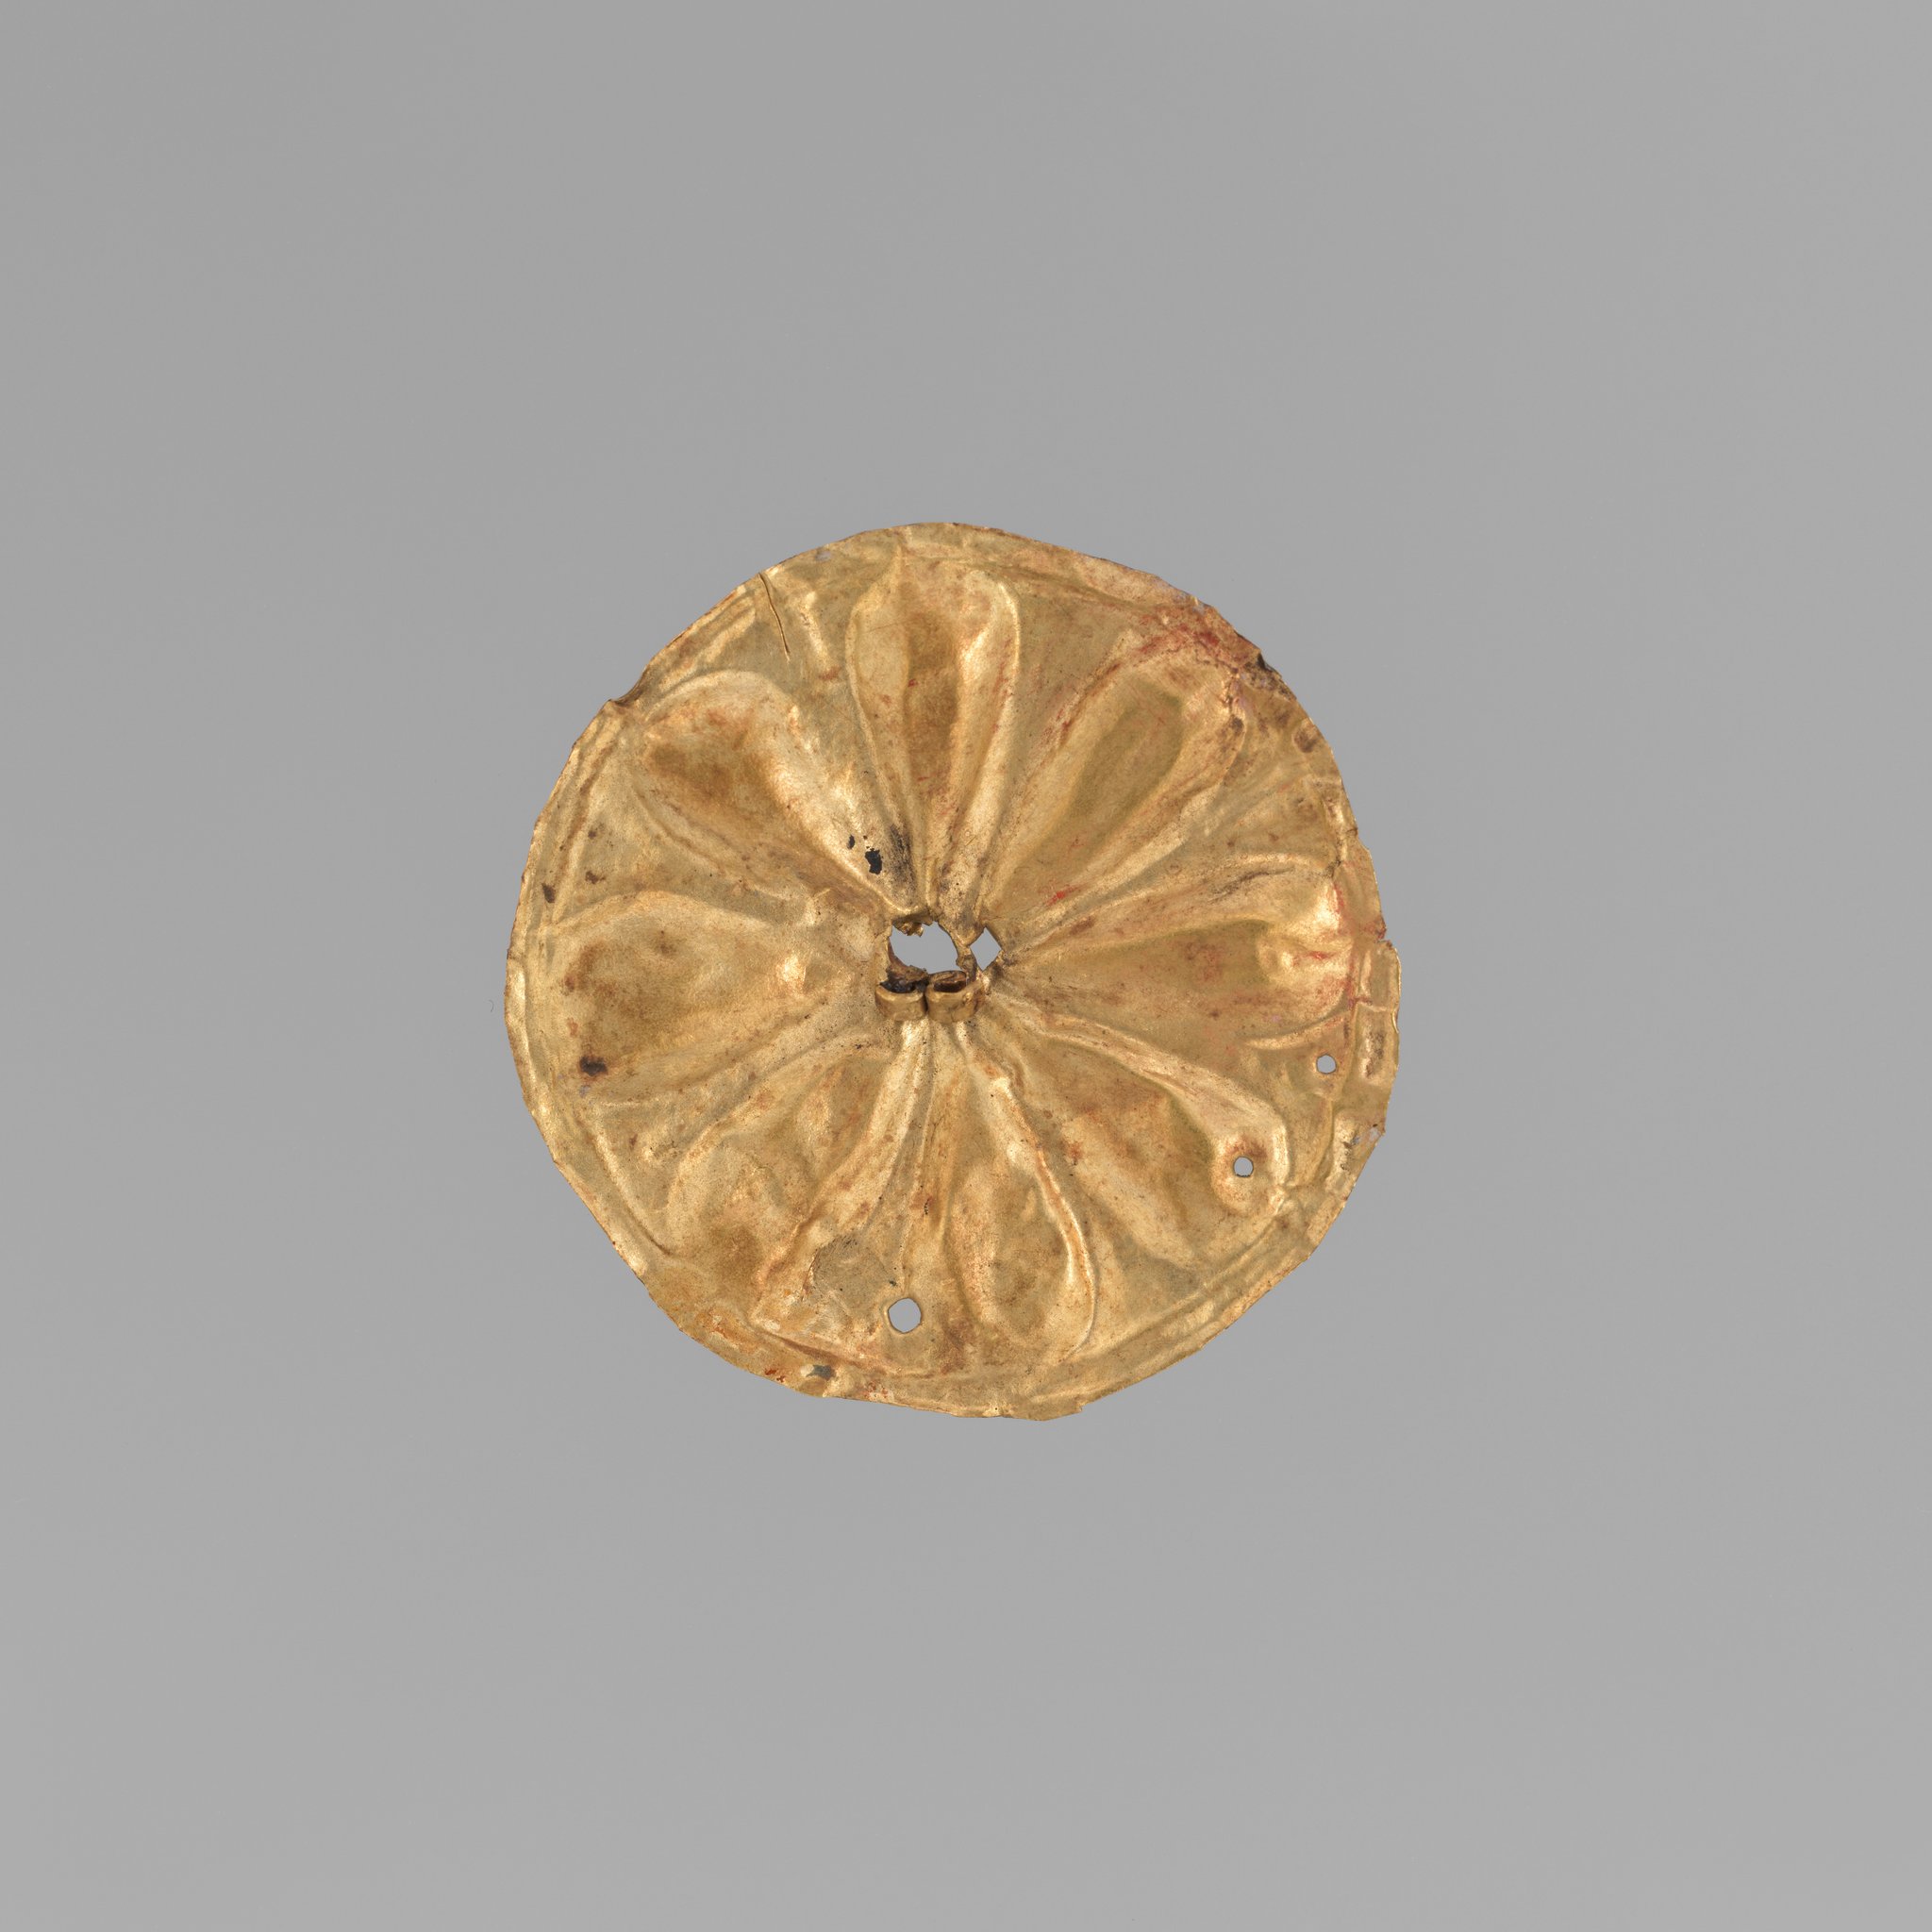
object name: roundel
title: Gold roundel with stamped designs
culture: cypriot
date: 1600-1050 BCE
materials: gold